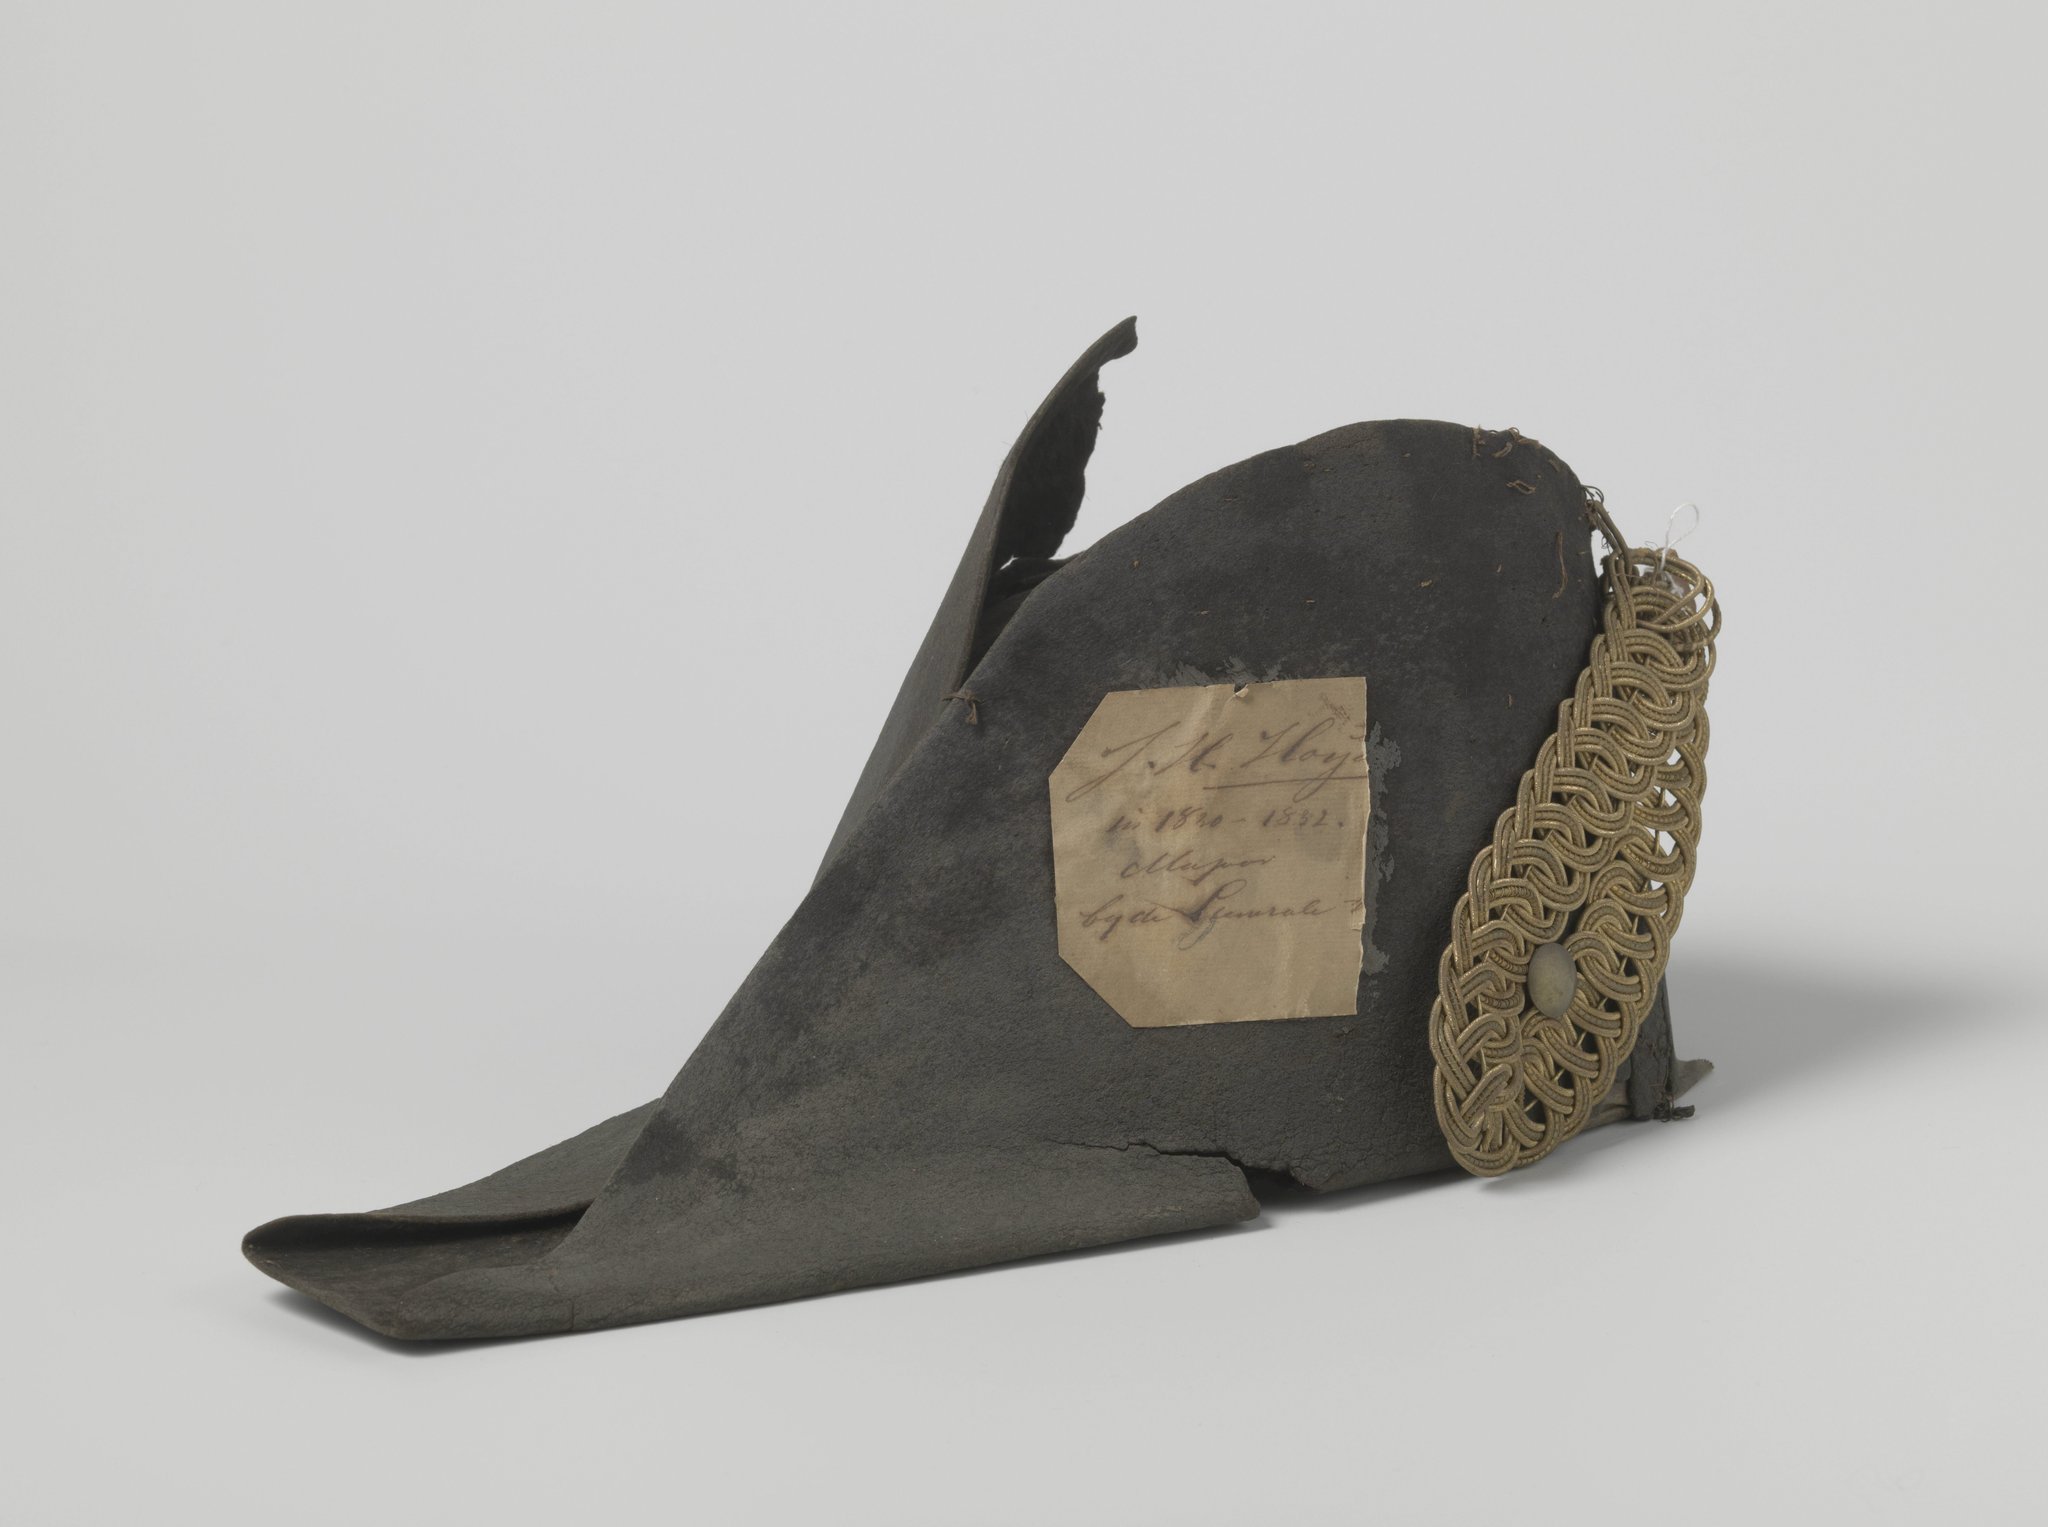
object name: bicorne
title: Bicorne officier Koninklijke Landmacht ca. 1830-1832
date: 1800-1850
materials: copper, felt, gold, leather, paper, silk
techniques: material, forming, pressing, printing, stitching, tanning, weave, writing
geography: the hague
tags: netherlands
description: Hoofddeksel (restant) van vergaan zwart vilt. Op bol leren draaglus, aan een zijden glad geel metalen knoop en restant van lis van gouddraad. Hieraan leren label met nr. 113. Binnenwerk: Naturel leren rand, met aan een zijden koord en op de bodem op Nederlands wapen: JE MAINTIENDRAI (bijna onleesbaar). Wit zijden voering op bodem goudstempel: Rijkswapen en W. Pauwels & zoon hofleveranciers van Z.M. de Koning 's Hage. Aan liszijde half etiket: J.H. Hoye... in 1830-1832 Majoor bij de generale.... los etiket: 's avonds van (?) den 21. october 1830 op het dek Z.M. Korvet Komeet, dag van het bombardement op den stad Antwerpen.